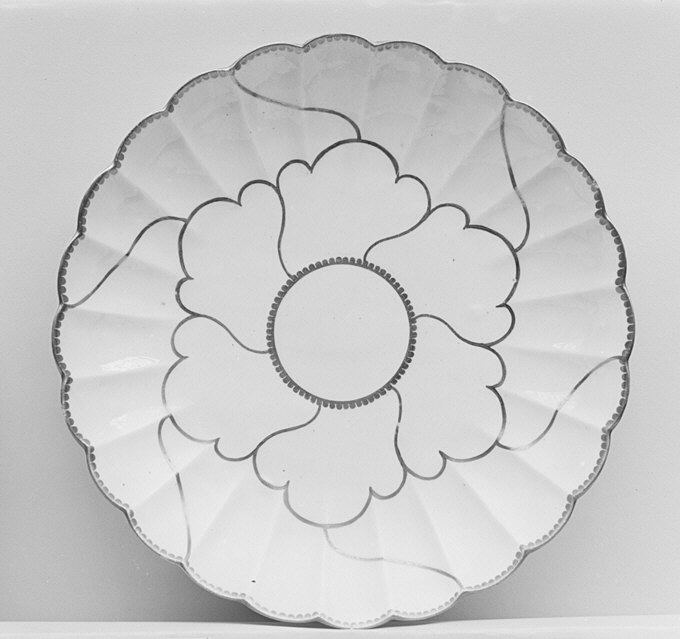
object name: dish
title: Dish (part of a service)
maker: worcester factory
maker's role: factory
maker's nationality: british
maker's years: 1751-2008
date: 1775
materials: soft paste porcelain